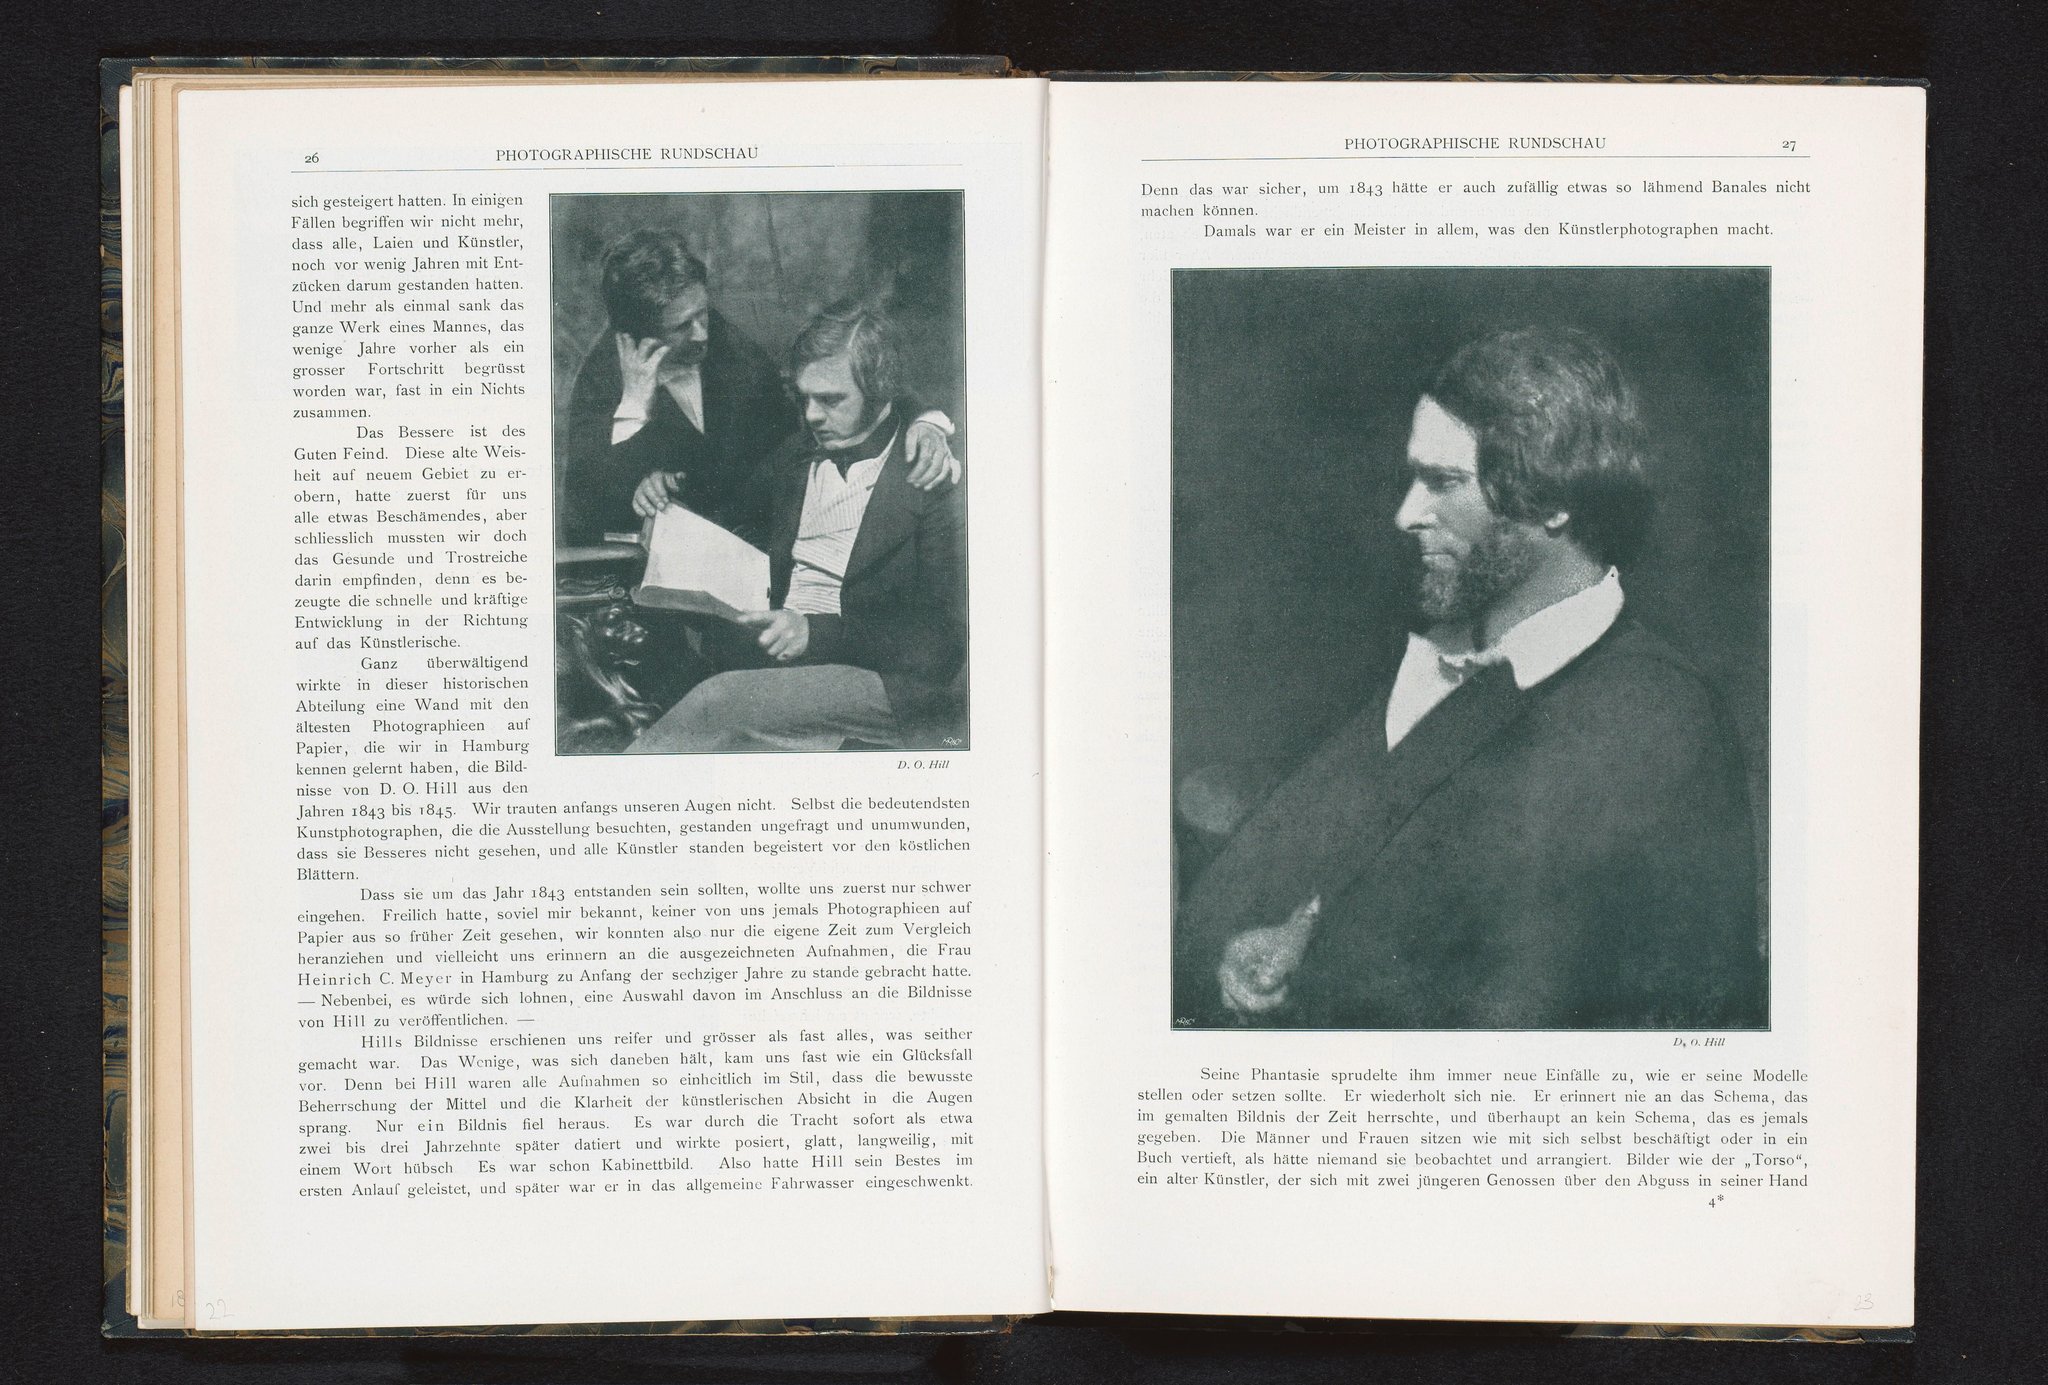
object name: photomechanical print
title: Portret van een onbekende man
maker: david octavius hill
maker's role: fotograaf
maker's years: 1802-1870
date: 1895-1900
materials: paper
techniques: autotype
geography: berlin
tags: adult man, anonymous historical person portrayed